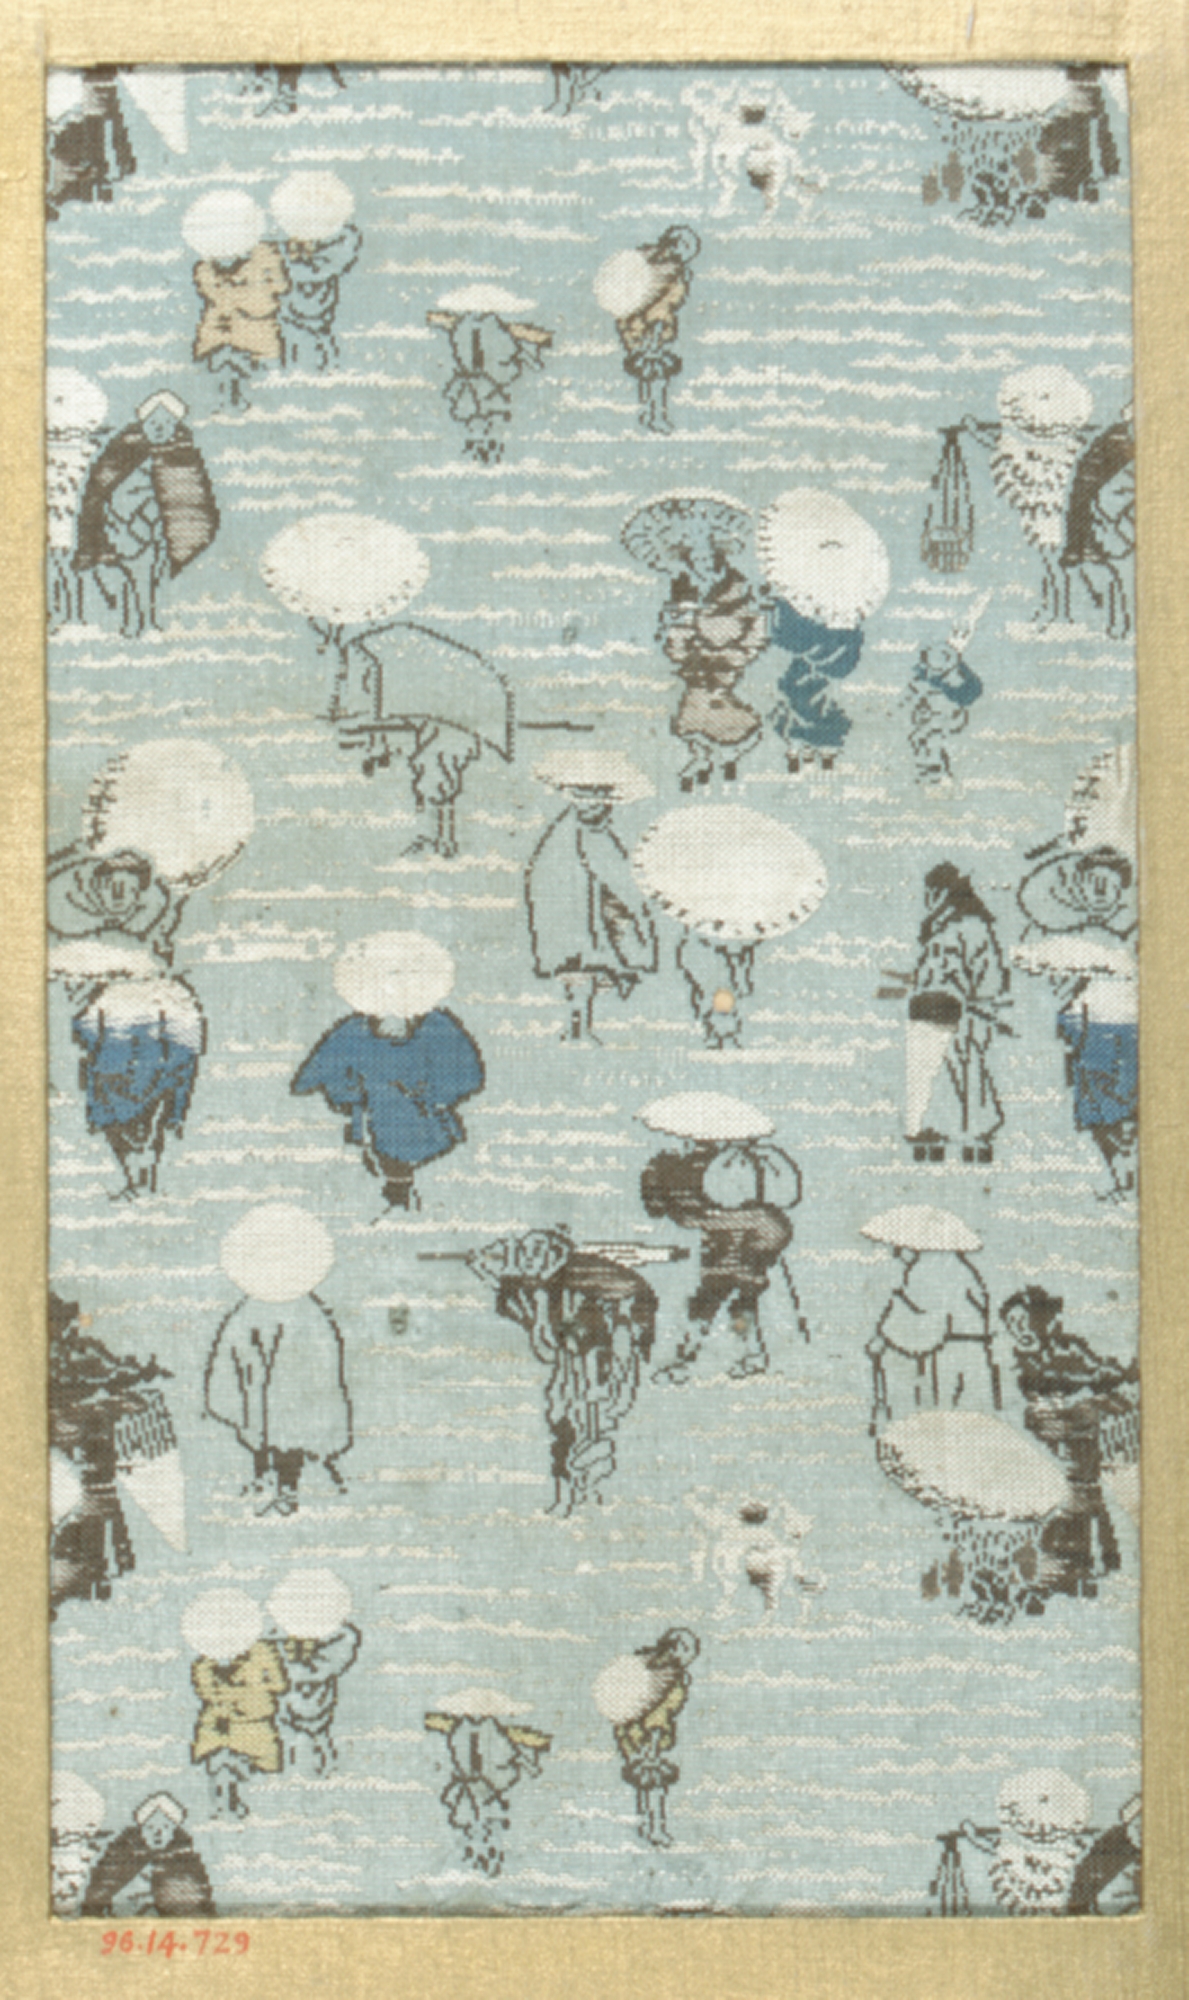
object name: piece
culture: japanese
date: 1701-1900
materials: silk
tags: human figures